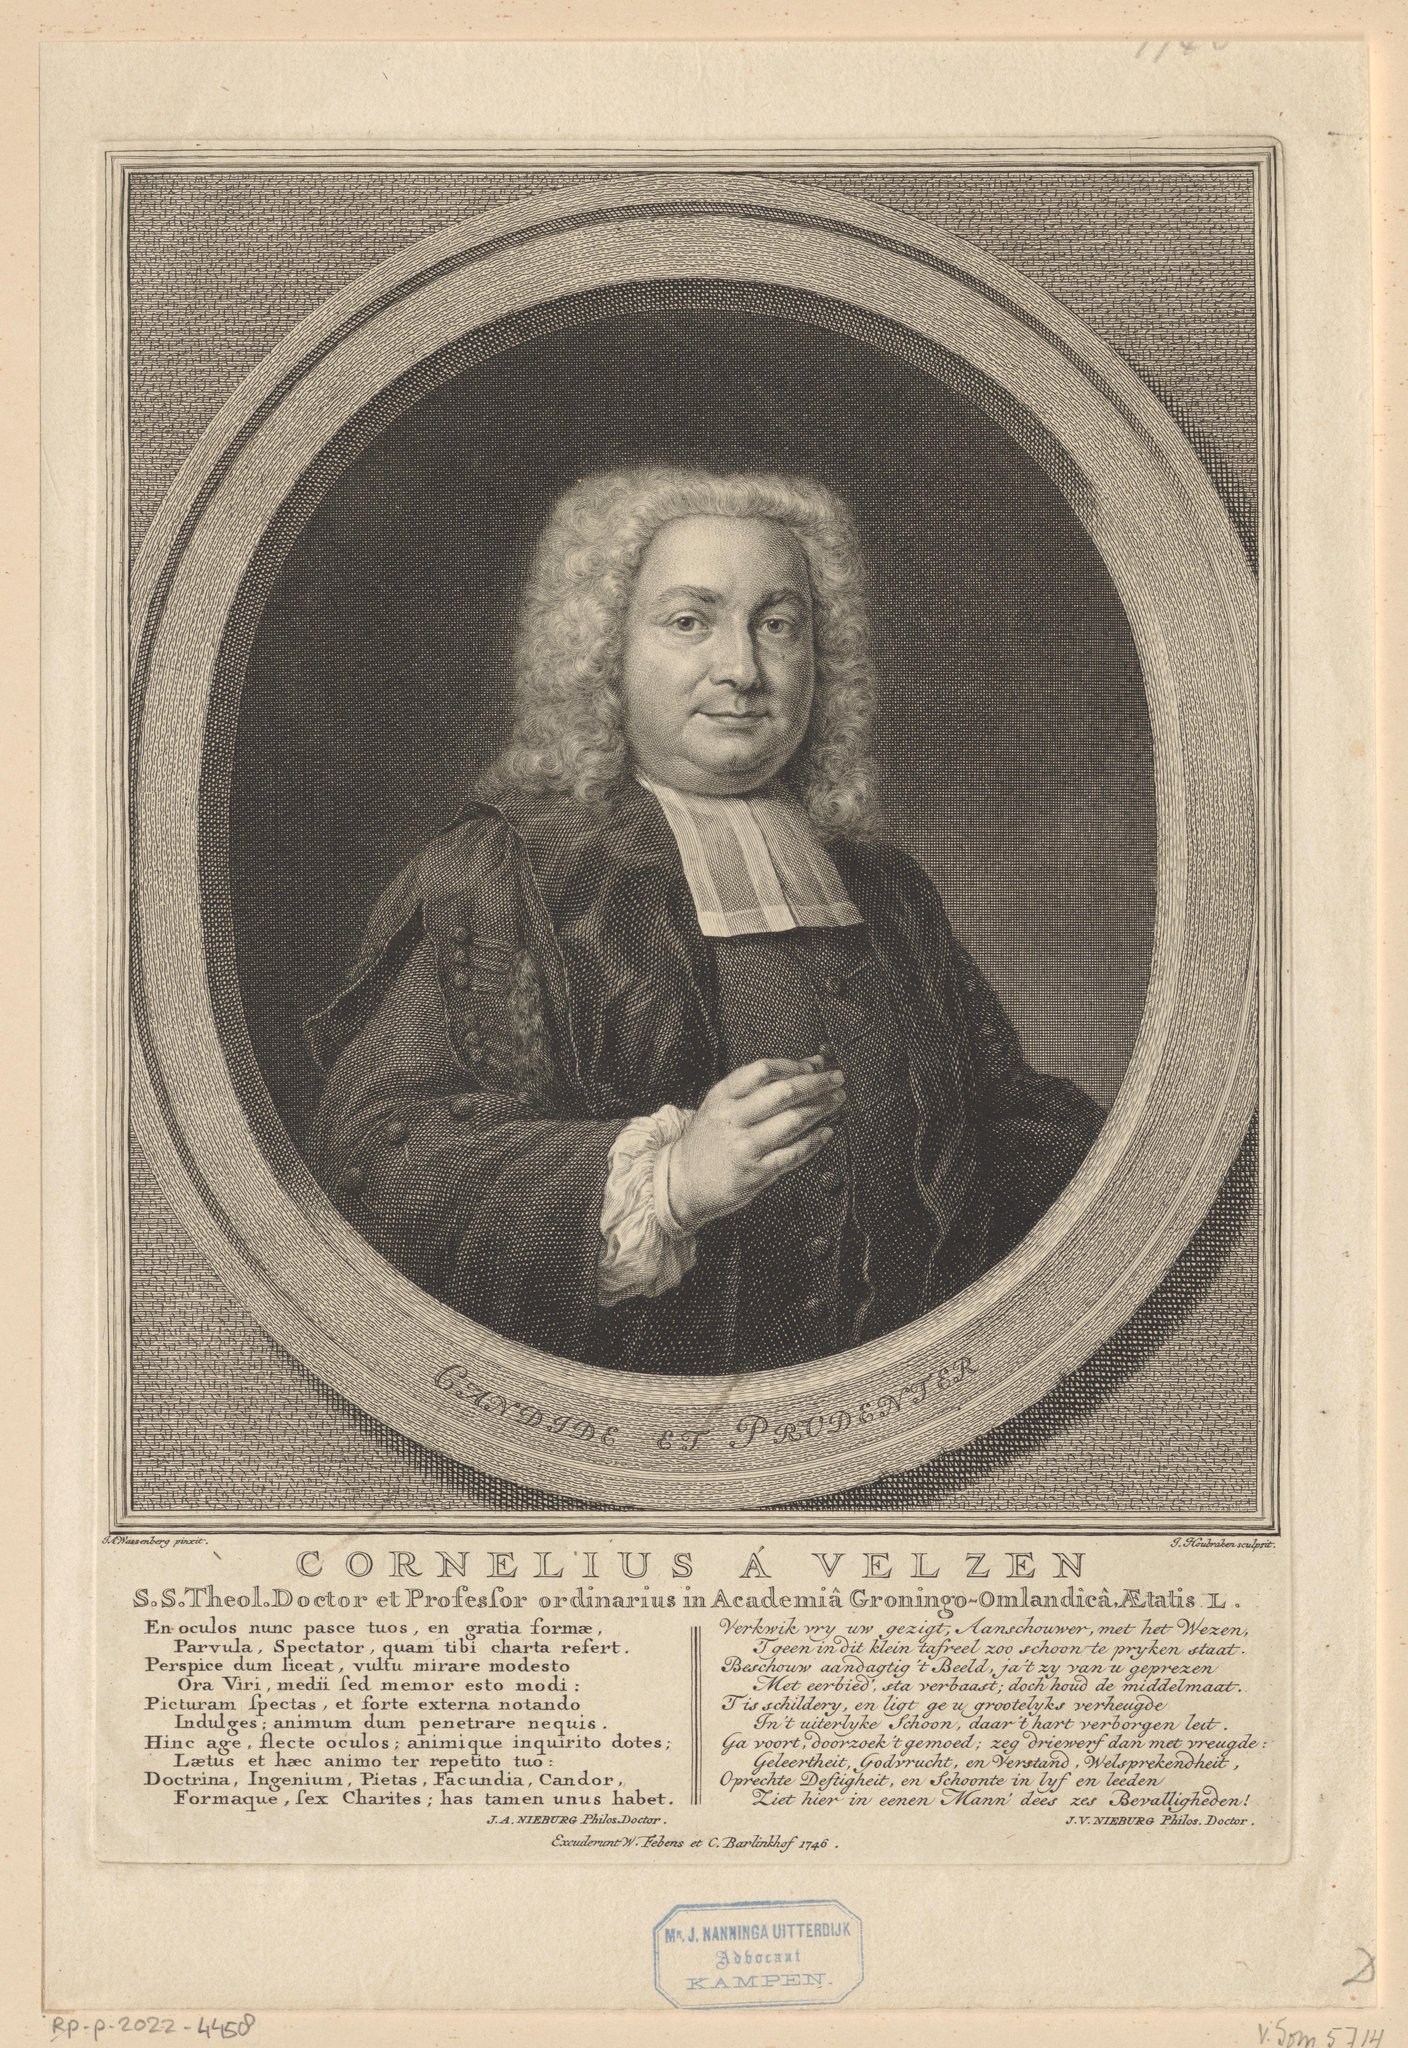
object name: print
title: Portret van Cornelius van Velzen op 50-jarige leeftijd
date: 1746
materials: paper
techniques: engraving, etching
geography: groningen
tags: theologian, historical persons, professor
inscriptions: stamp: ‘Mr. J. Nanninga Uitterdijk Advocaat Kampen’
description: Onder het portret een tienregelig onderschrift in het Latijn en een tienregelig vers in het Nederlands, in twee kolommen.